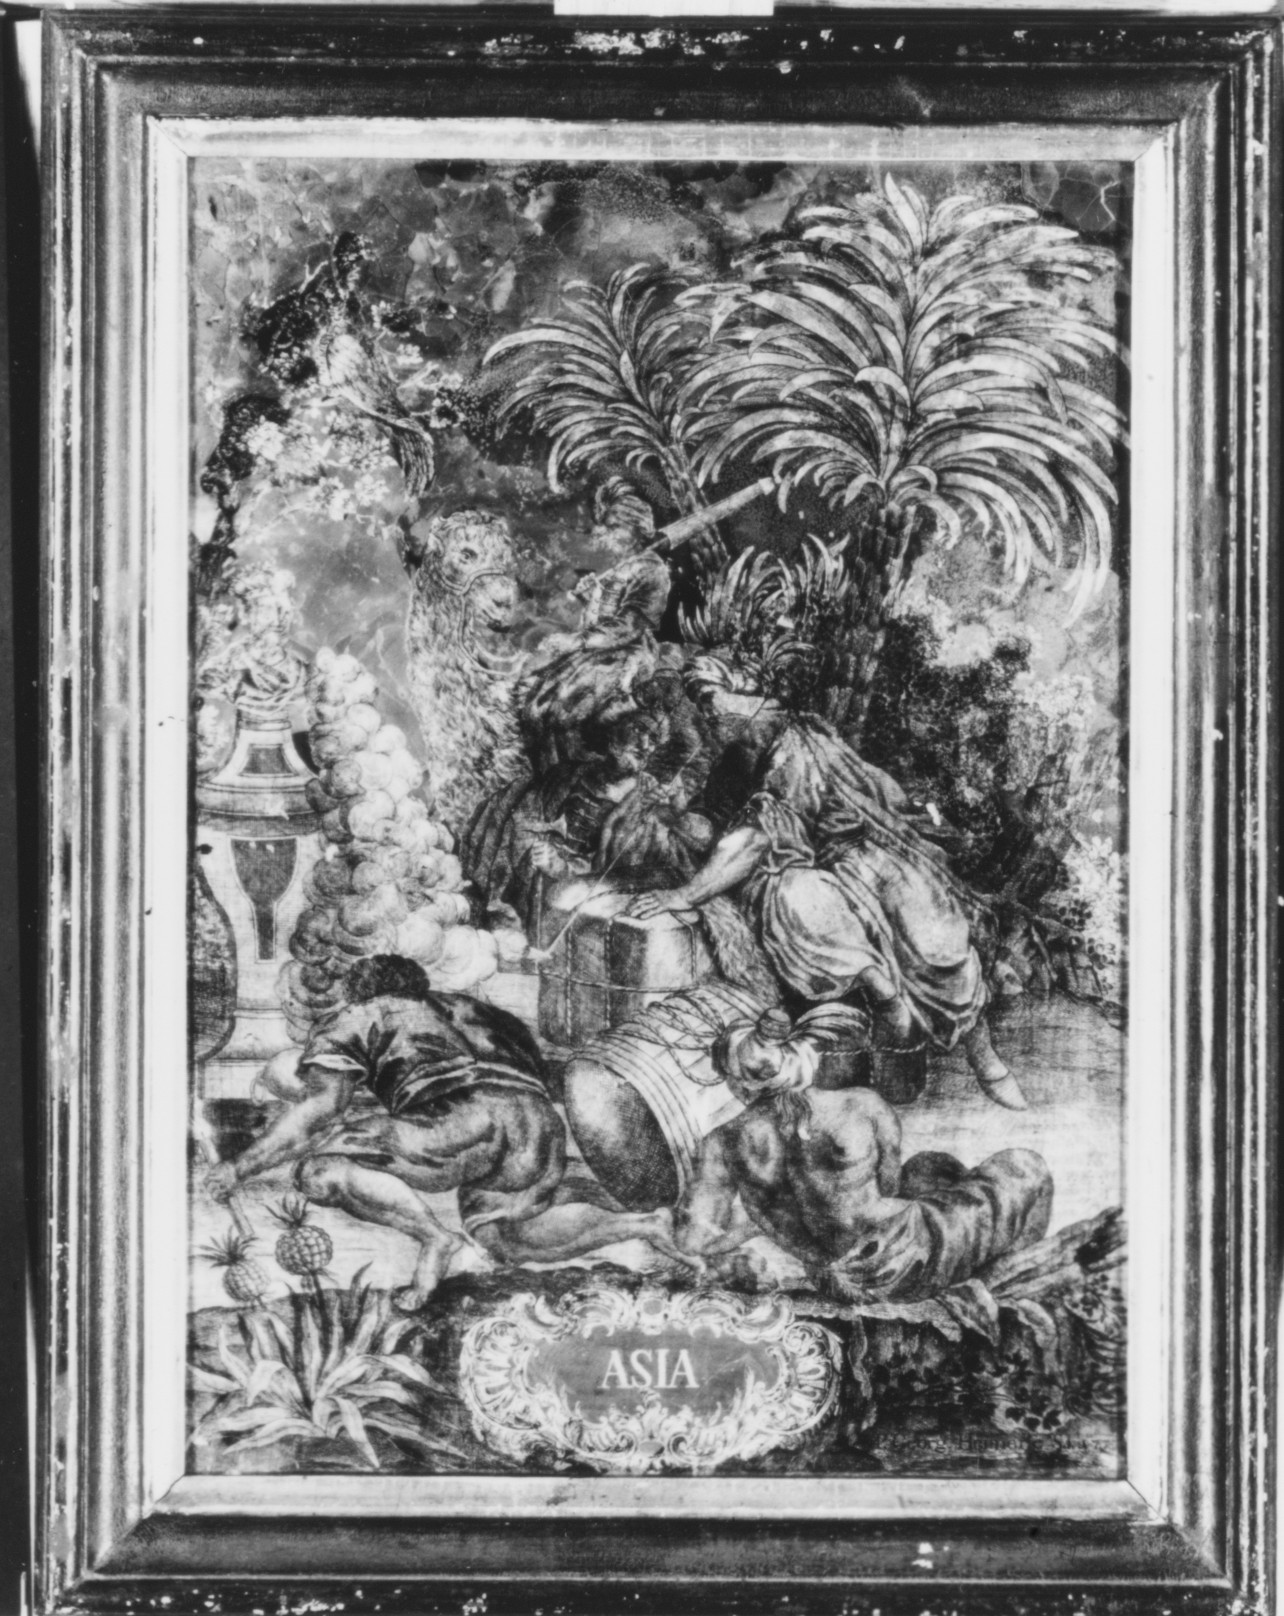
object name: panel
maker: georg henner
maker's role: artist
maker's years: 1727-1827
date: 1777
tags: men,camels